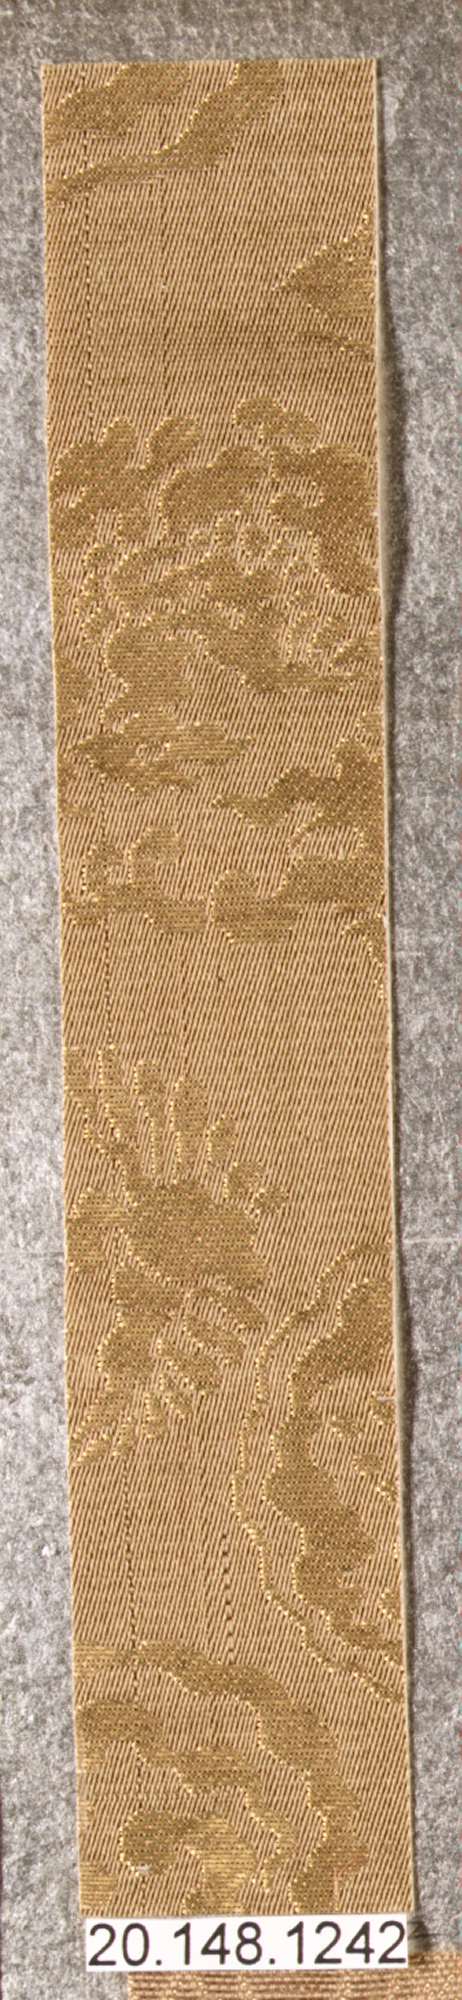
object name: piece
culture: japanese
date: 1801-1900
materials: silk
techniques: compound weave